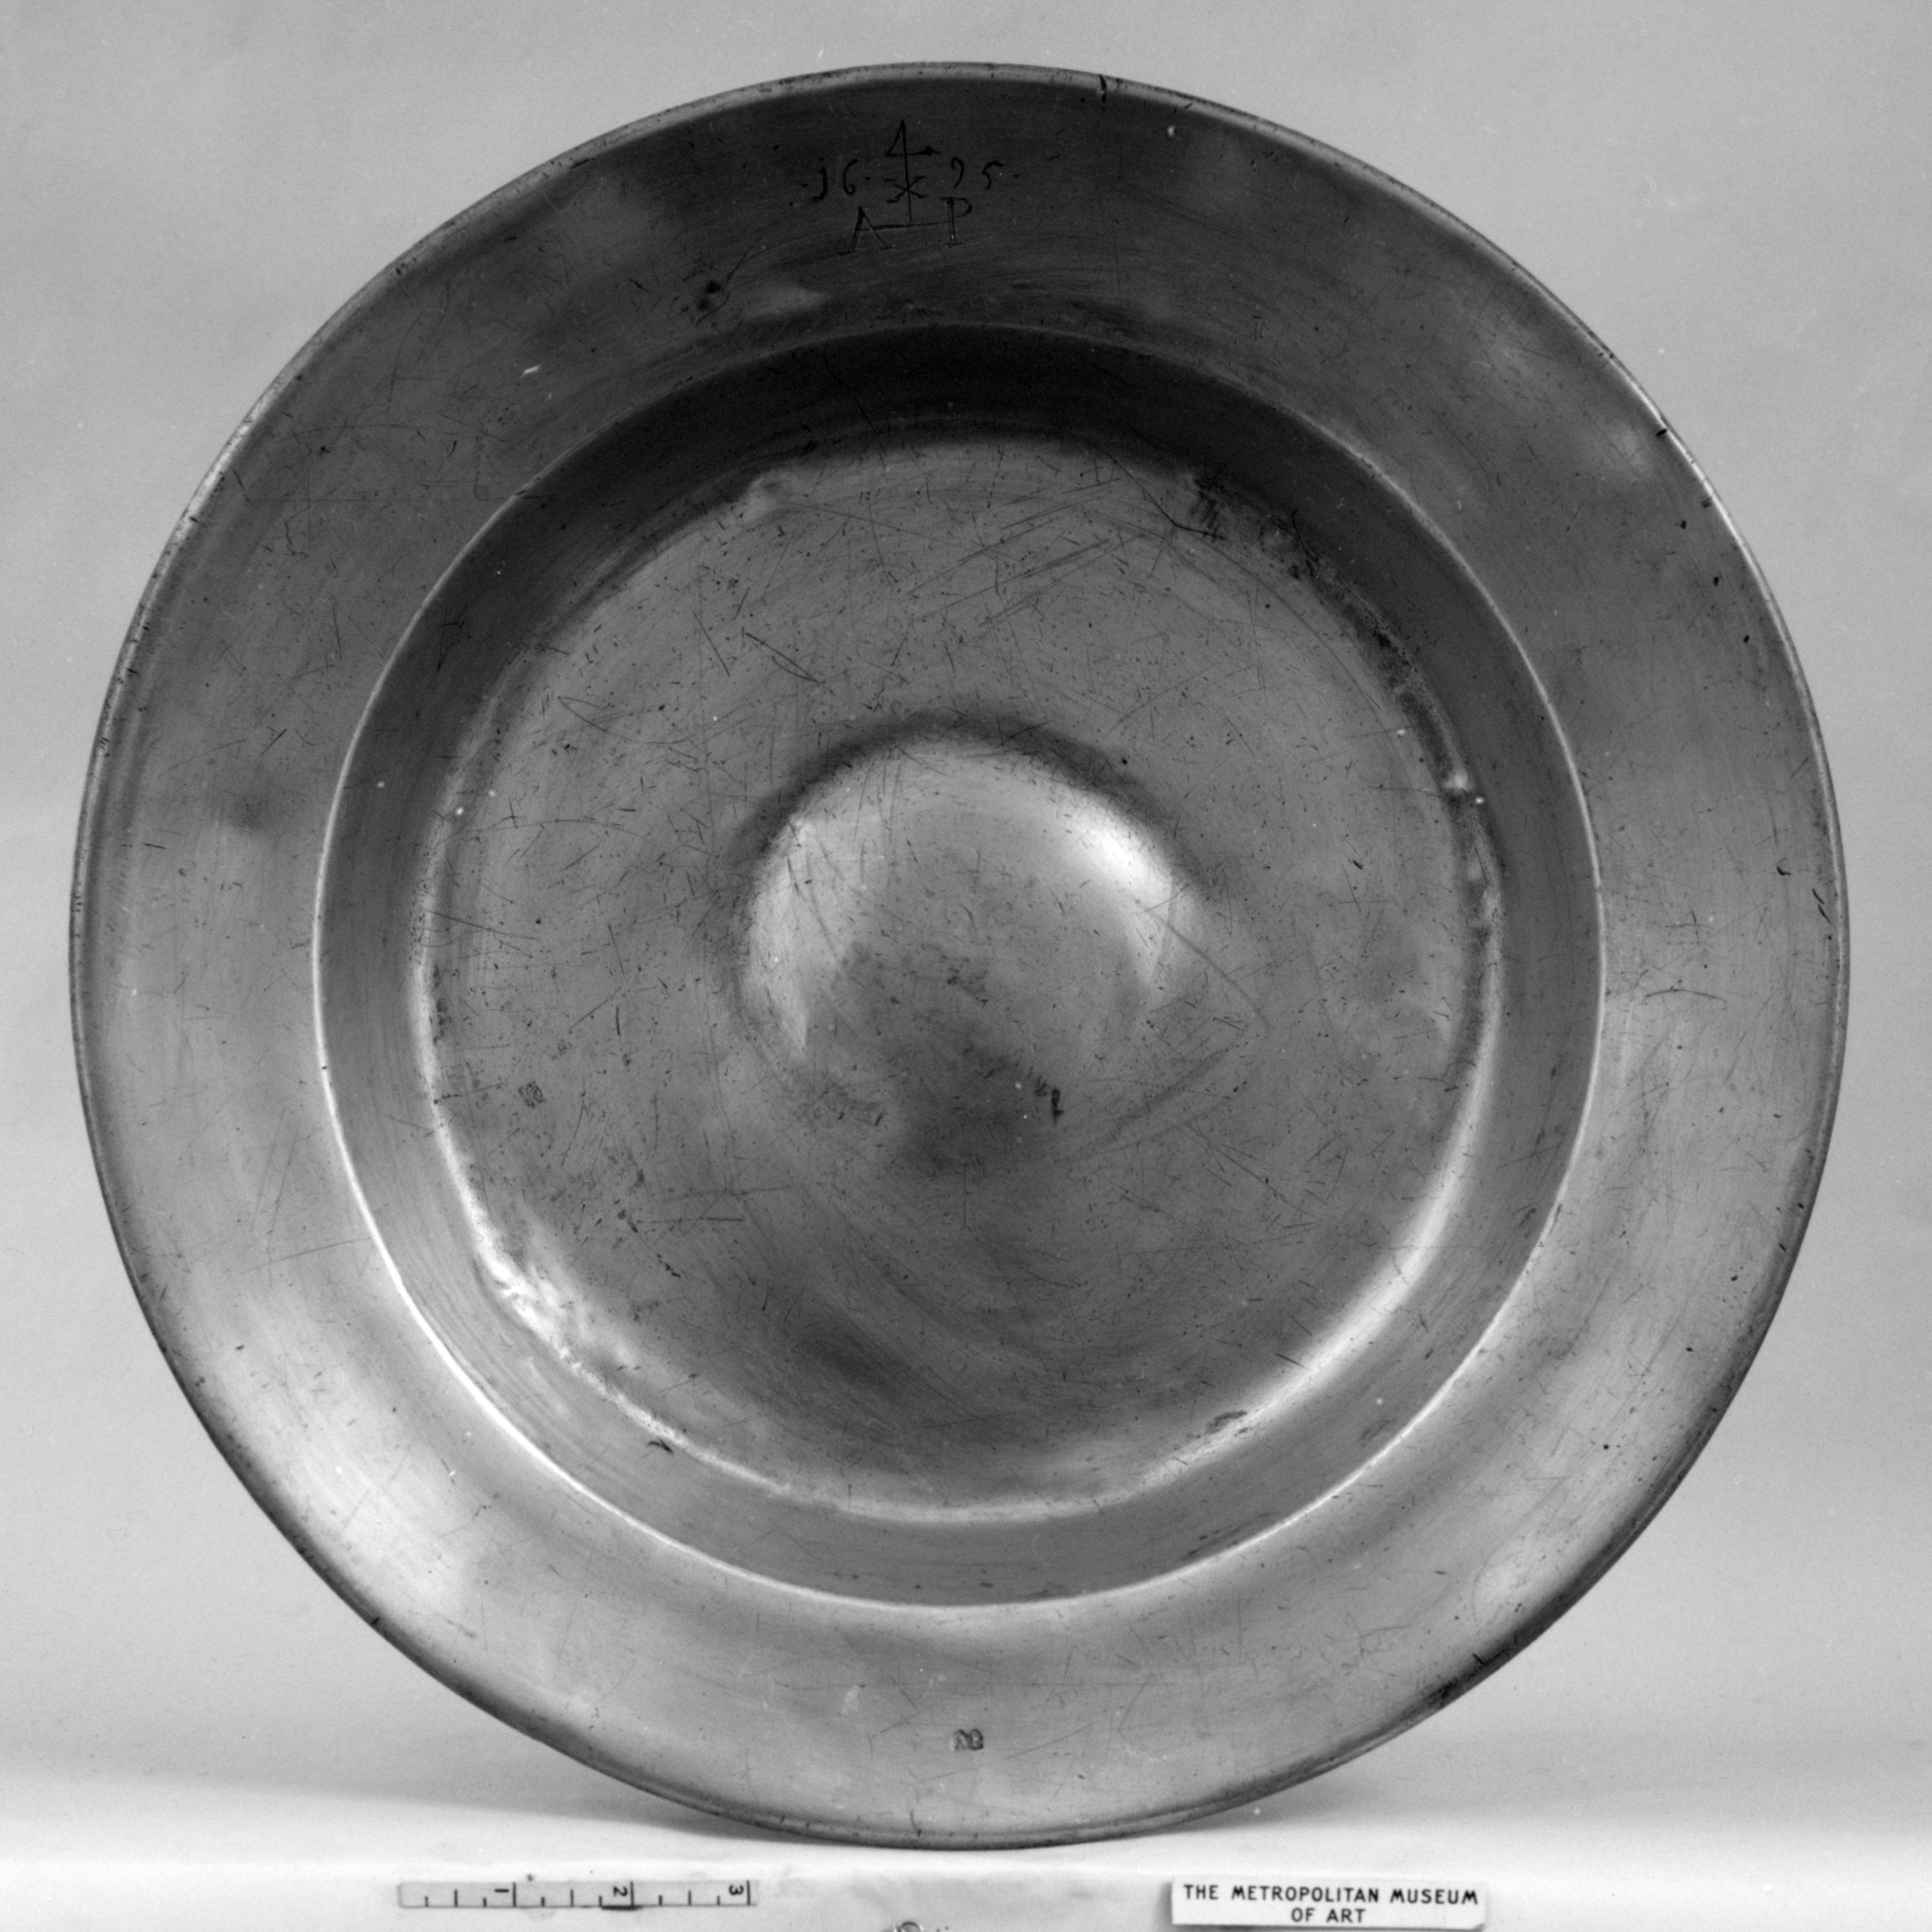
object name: dish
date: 1651-1700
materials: pewter